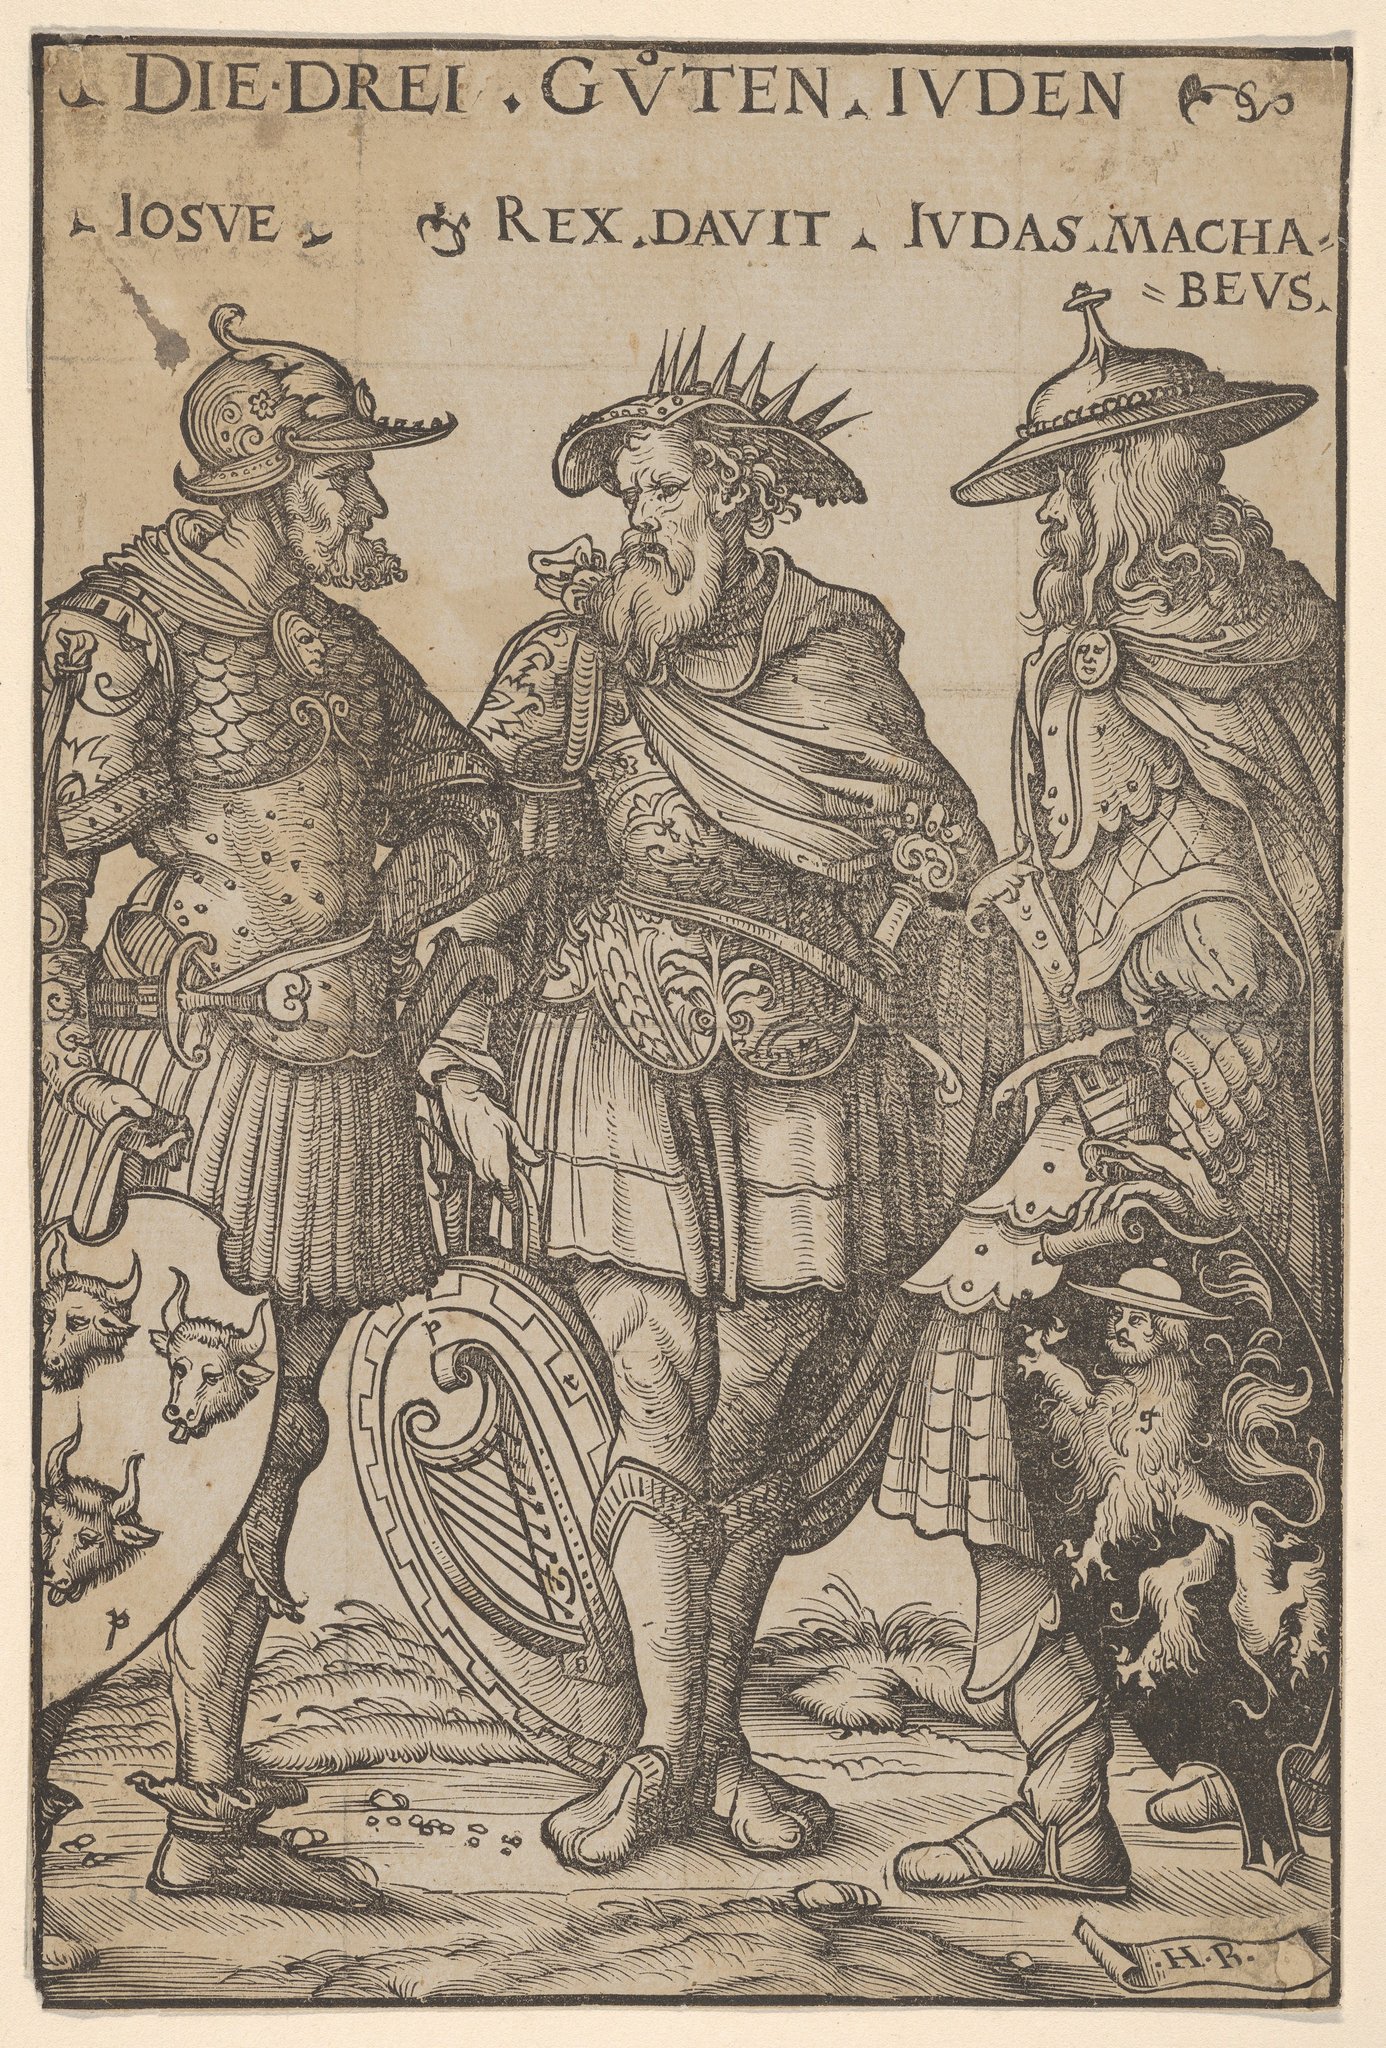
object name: print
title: The Three Jewish Heroes (Die Drei Guten Juden), from "Heroes and Heroines"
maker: hans burgkmair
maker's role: artist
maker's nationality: german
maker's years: 1473-1531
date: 1516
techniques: woodcut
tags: shields,joshua,david,coat of arms